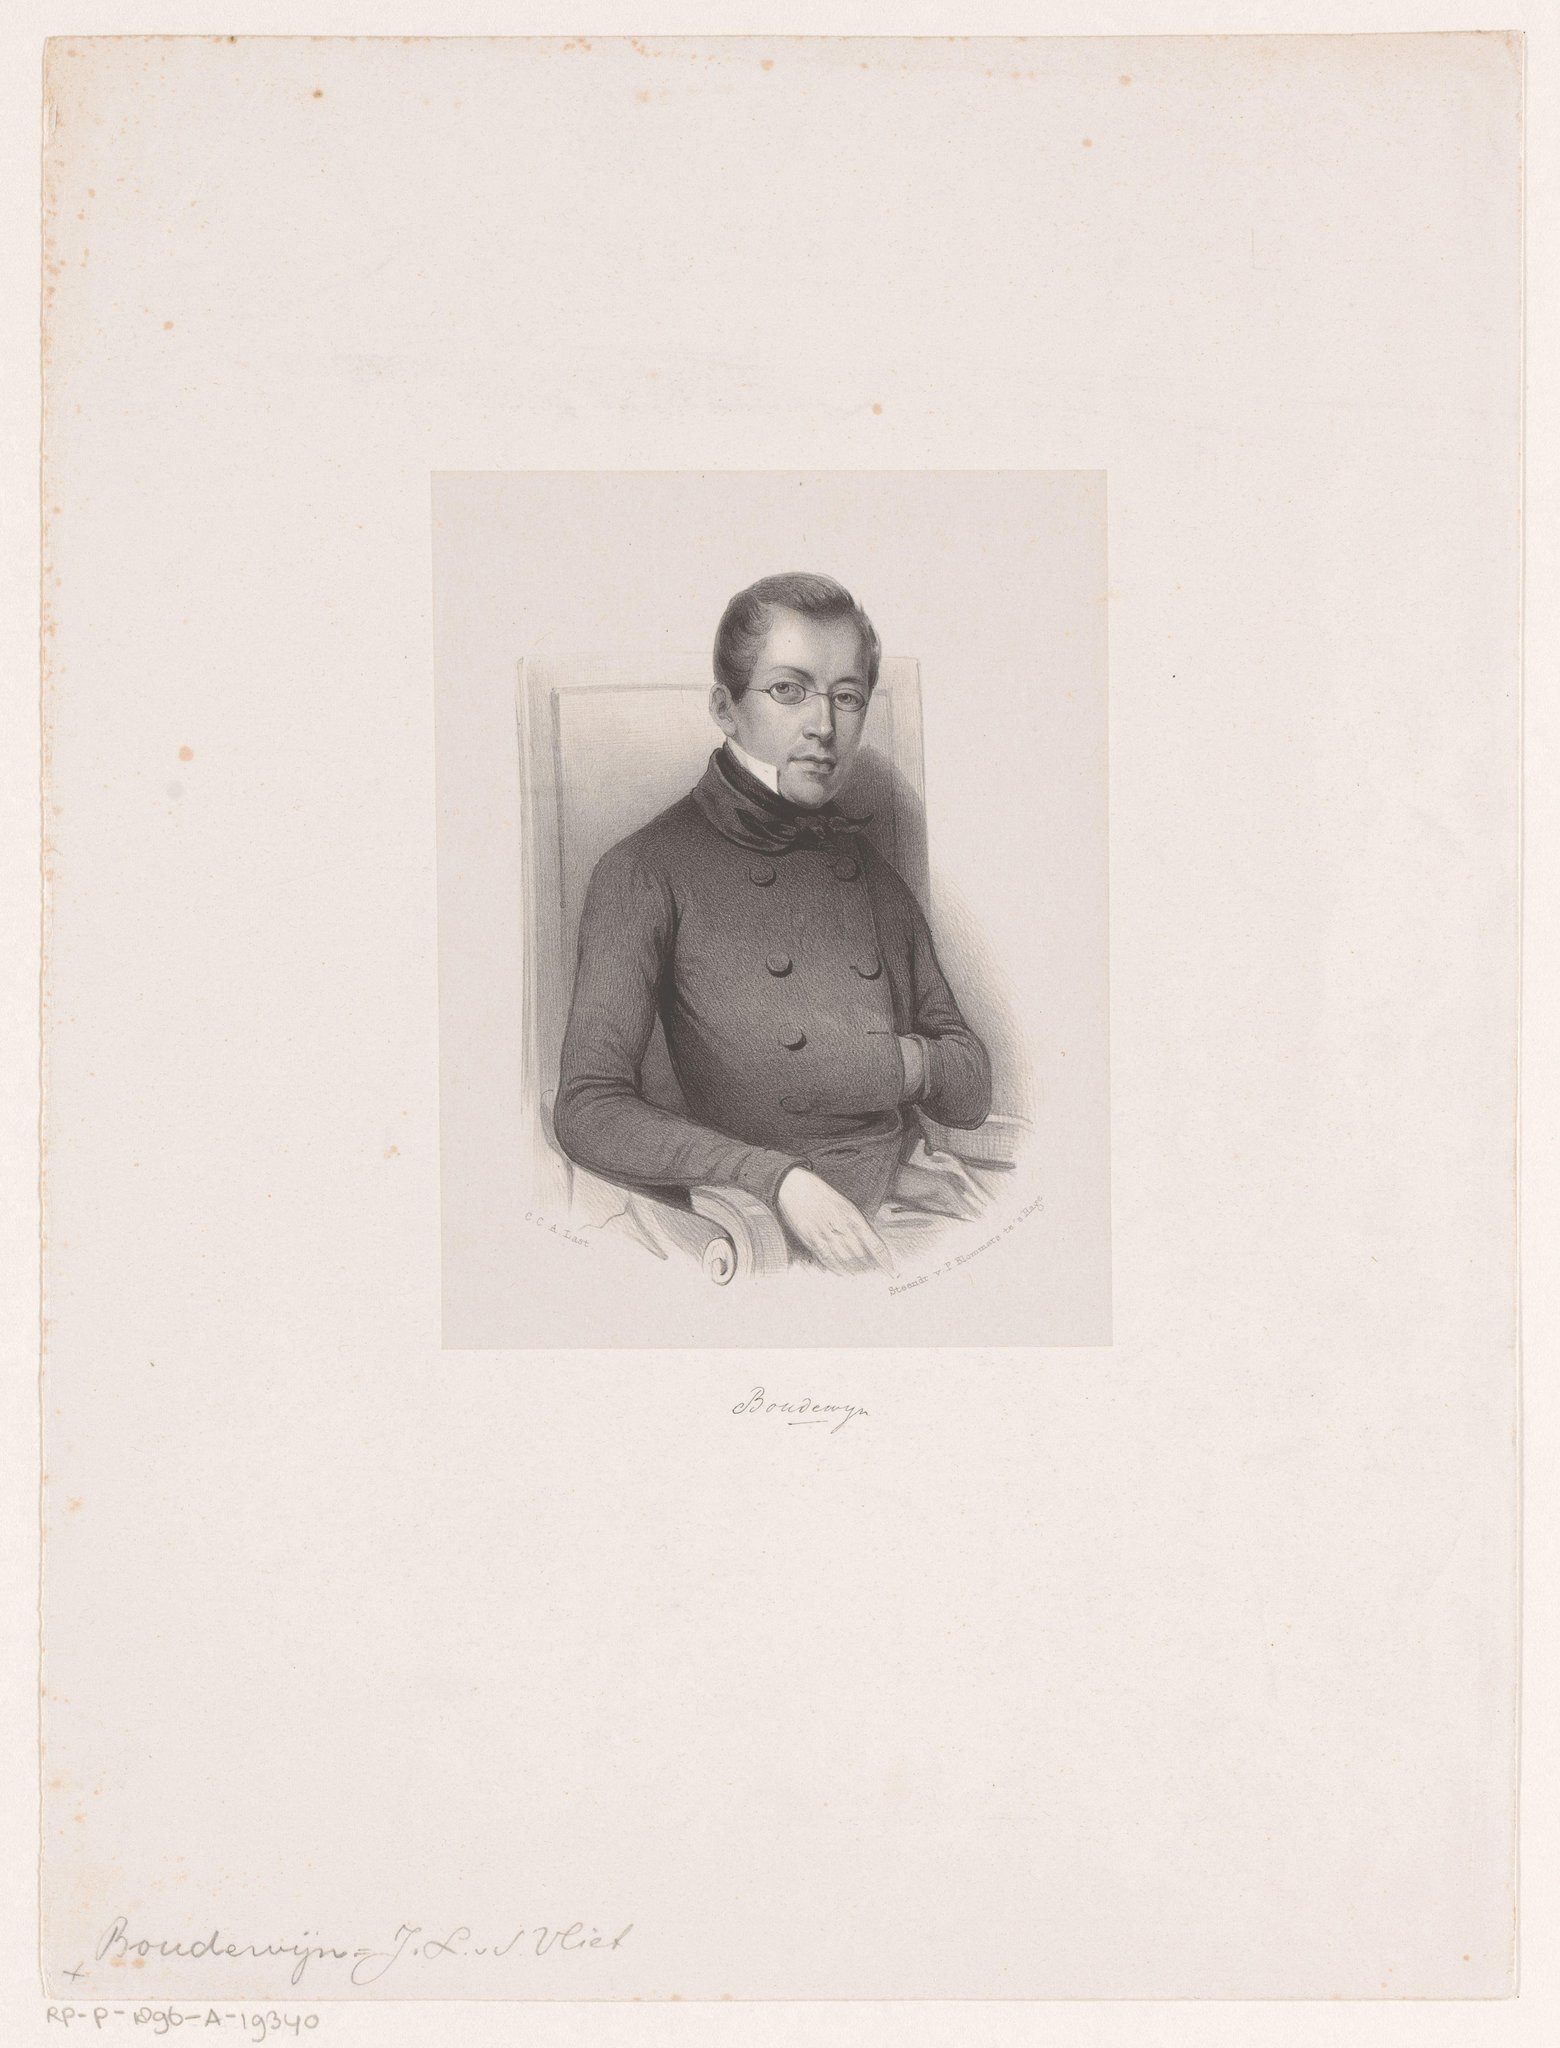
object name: print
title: Portret van Jacobus Leunis van der Vliet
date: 1842-1851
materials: paper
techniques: lithograph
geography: the hague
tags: the hague, hand on breast (or stomach), slipped into opening of vestment, historical persons (+ half-length portrait)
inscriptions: collector's mark: Lugt 2228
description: De geportretteerde heeft zijn linkerhand in zijn vest gestoken. Onder het portret zijn pseudoniem: Boudewijn.